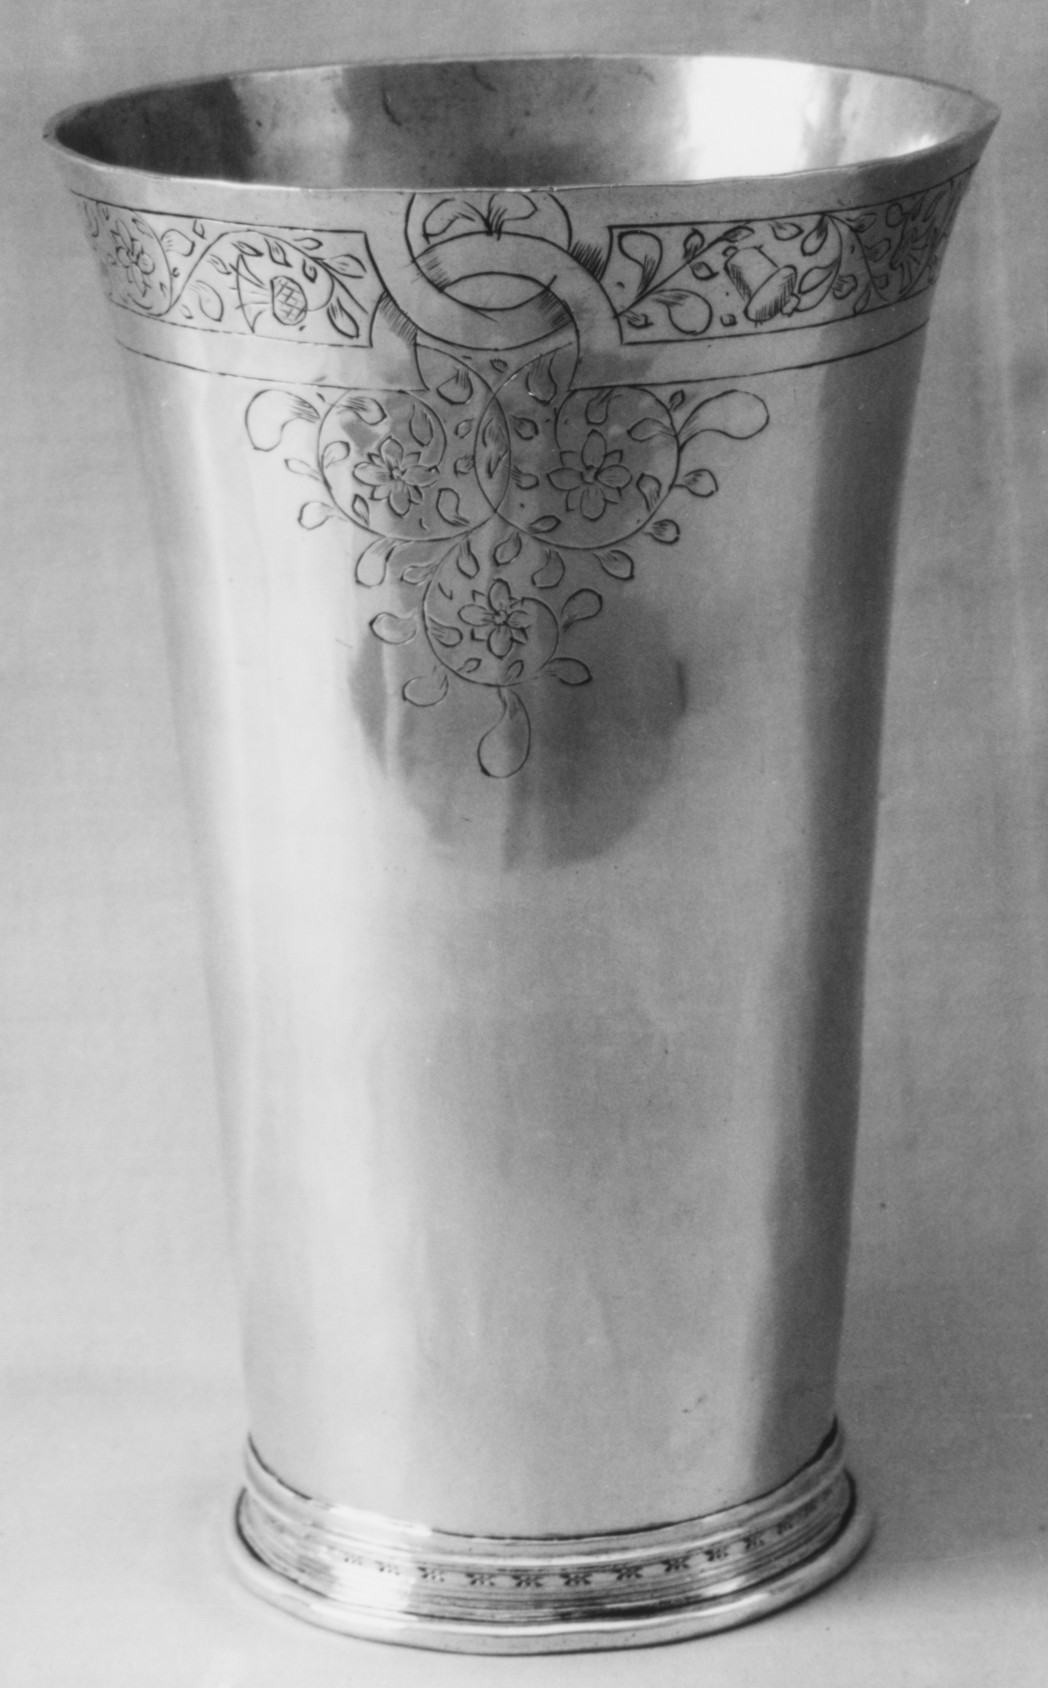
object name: beaker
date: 1601-1700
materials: silver